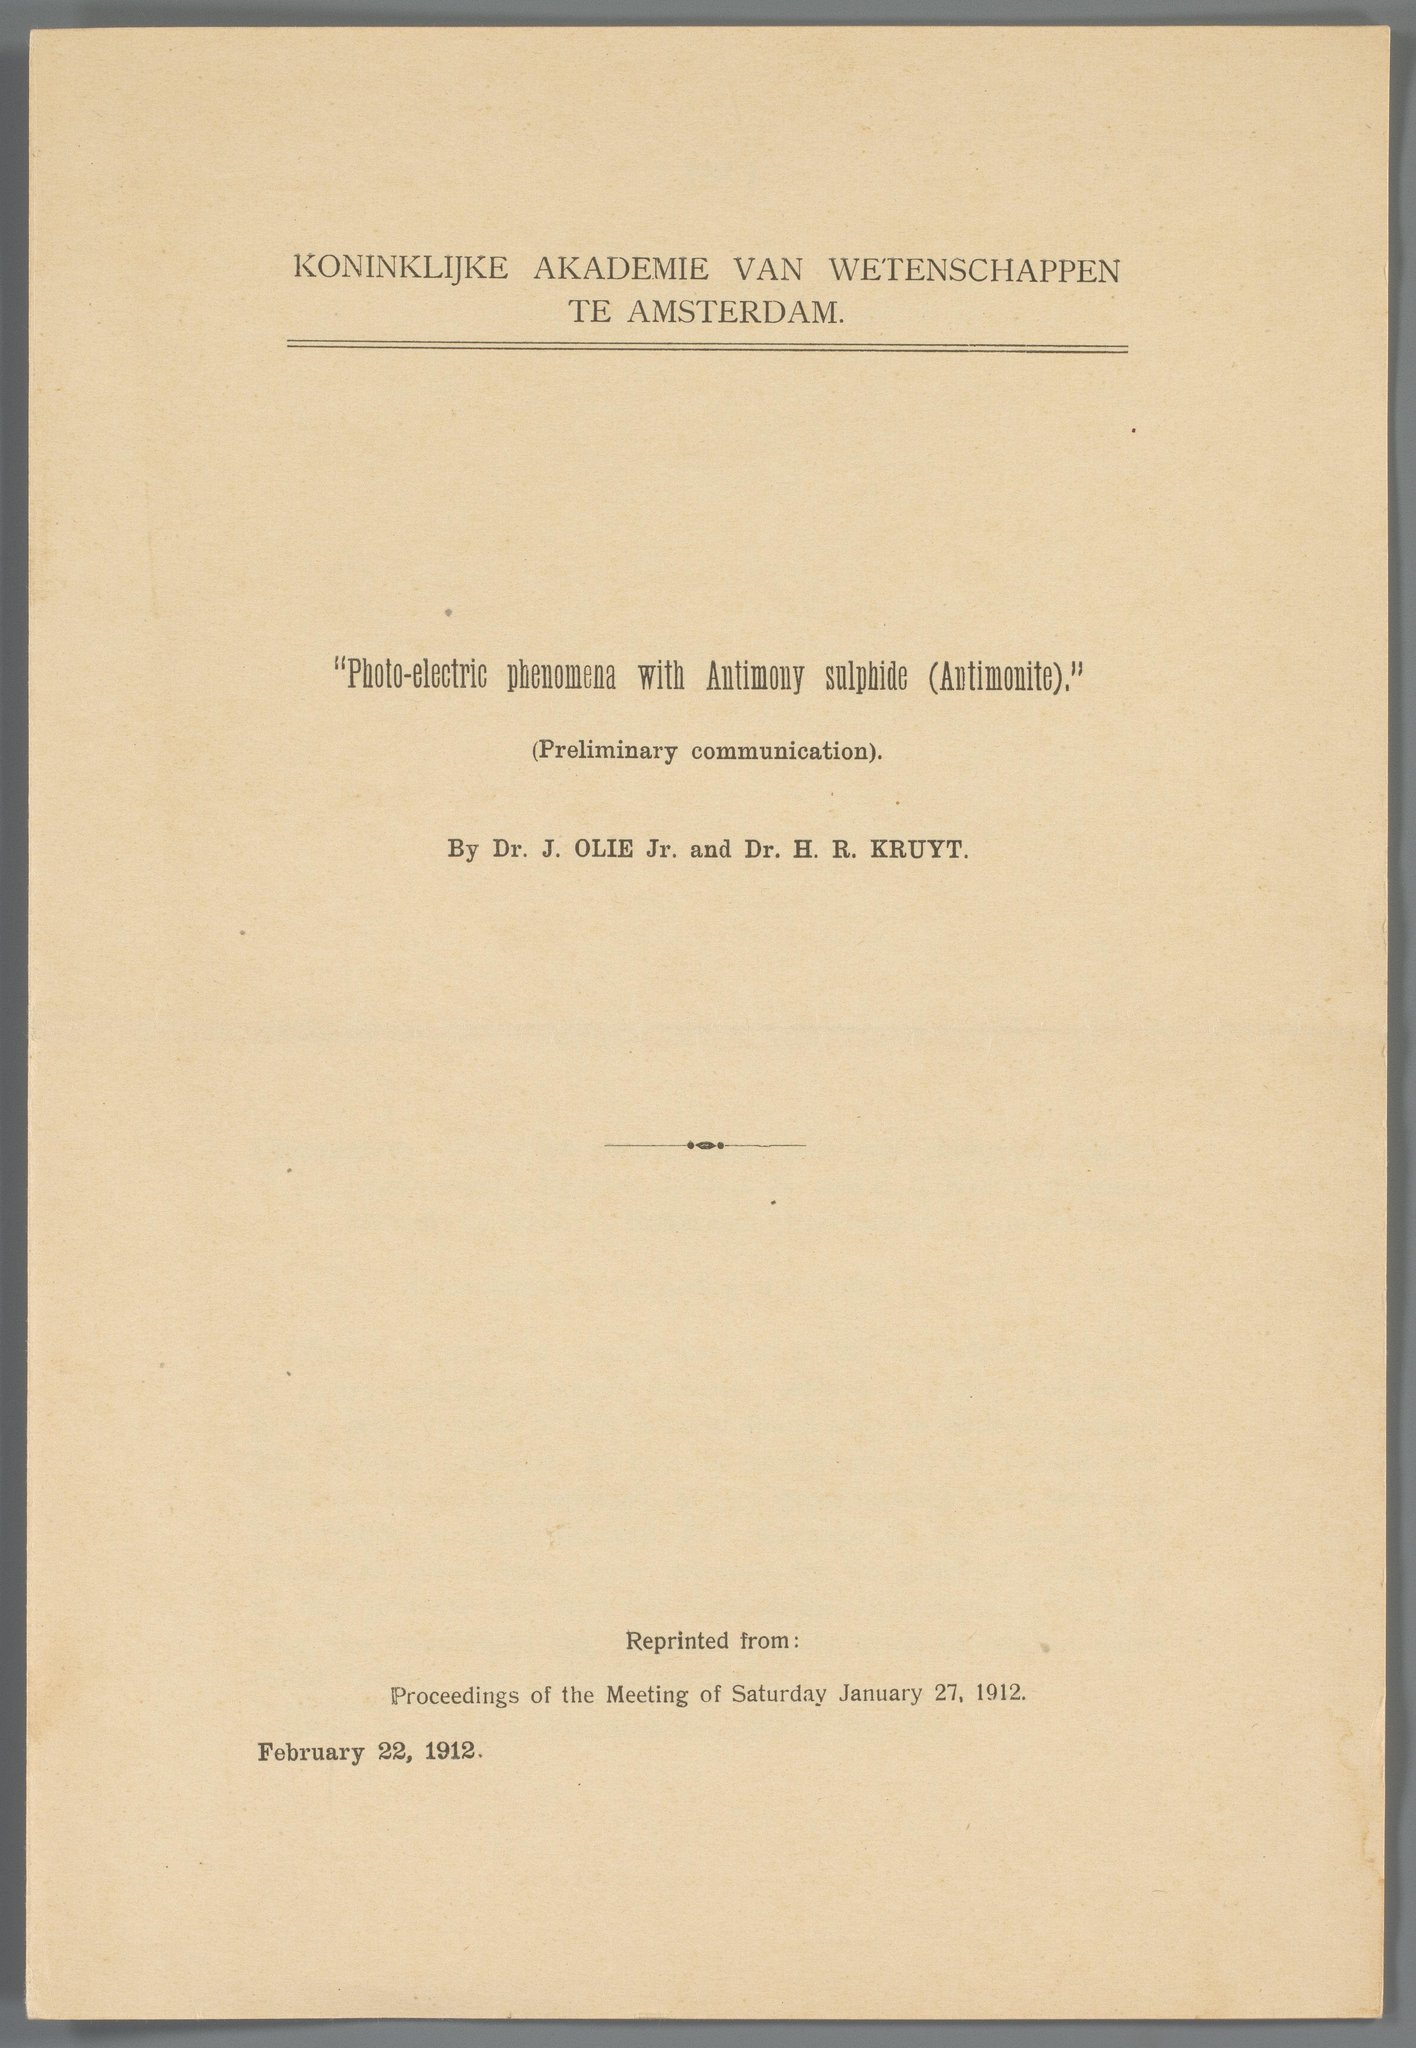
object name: offprint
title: Koninklijke Akademie van Wetenschappen te Amsterdam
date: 1912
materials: paper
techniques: letterpress printing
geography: utrecht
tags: chemistry (+ scholar, scientist (at work)), experiment, test ~ science and technology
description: Overdruk uit het verslag van de vergadering van de Koninklijke Akademie van Wetenschappen Amsterdam op zaterdag 27 januari 1912.